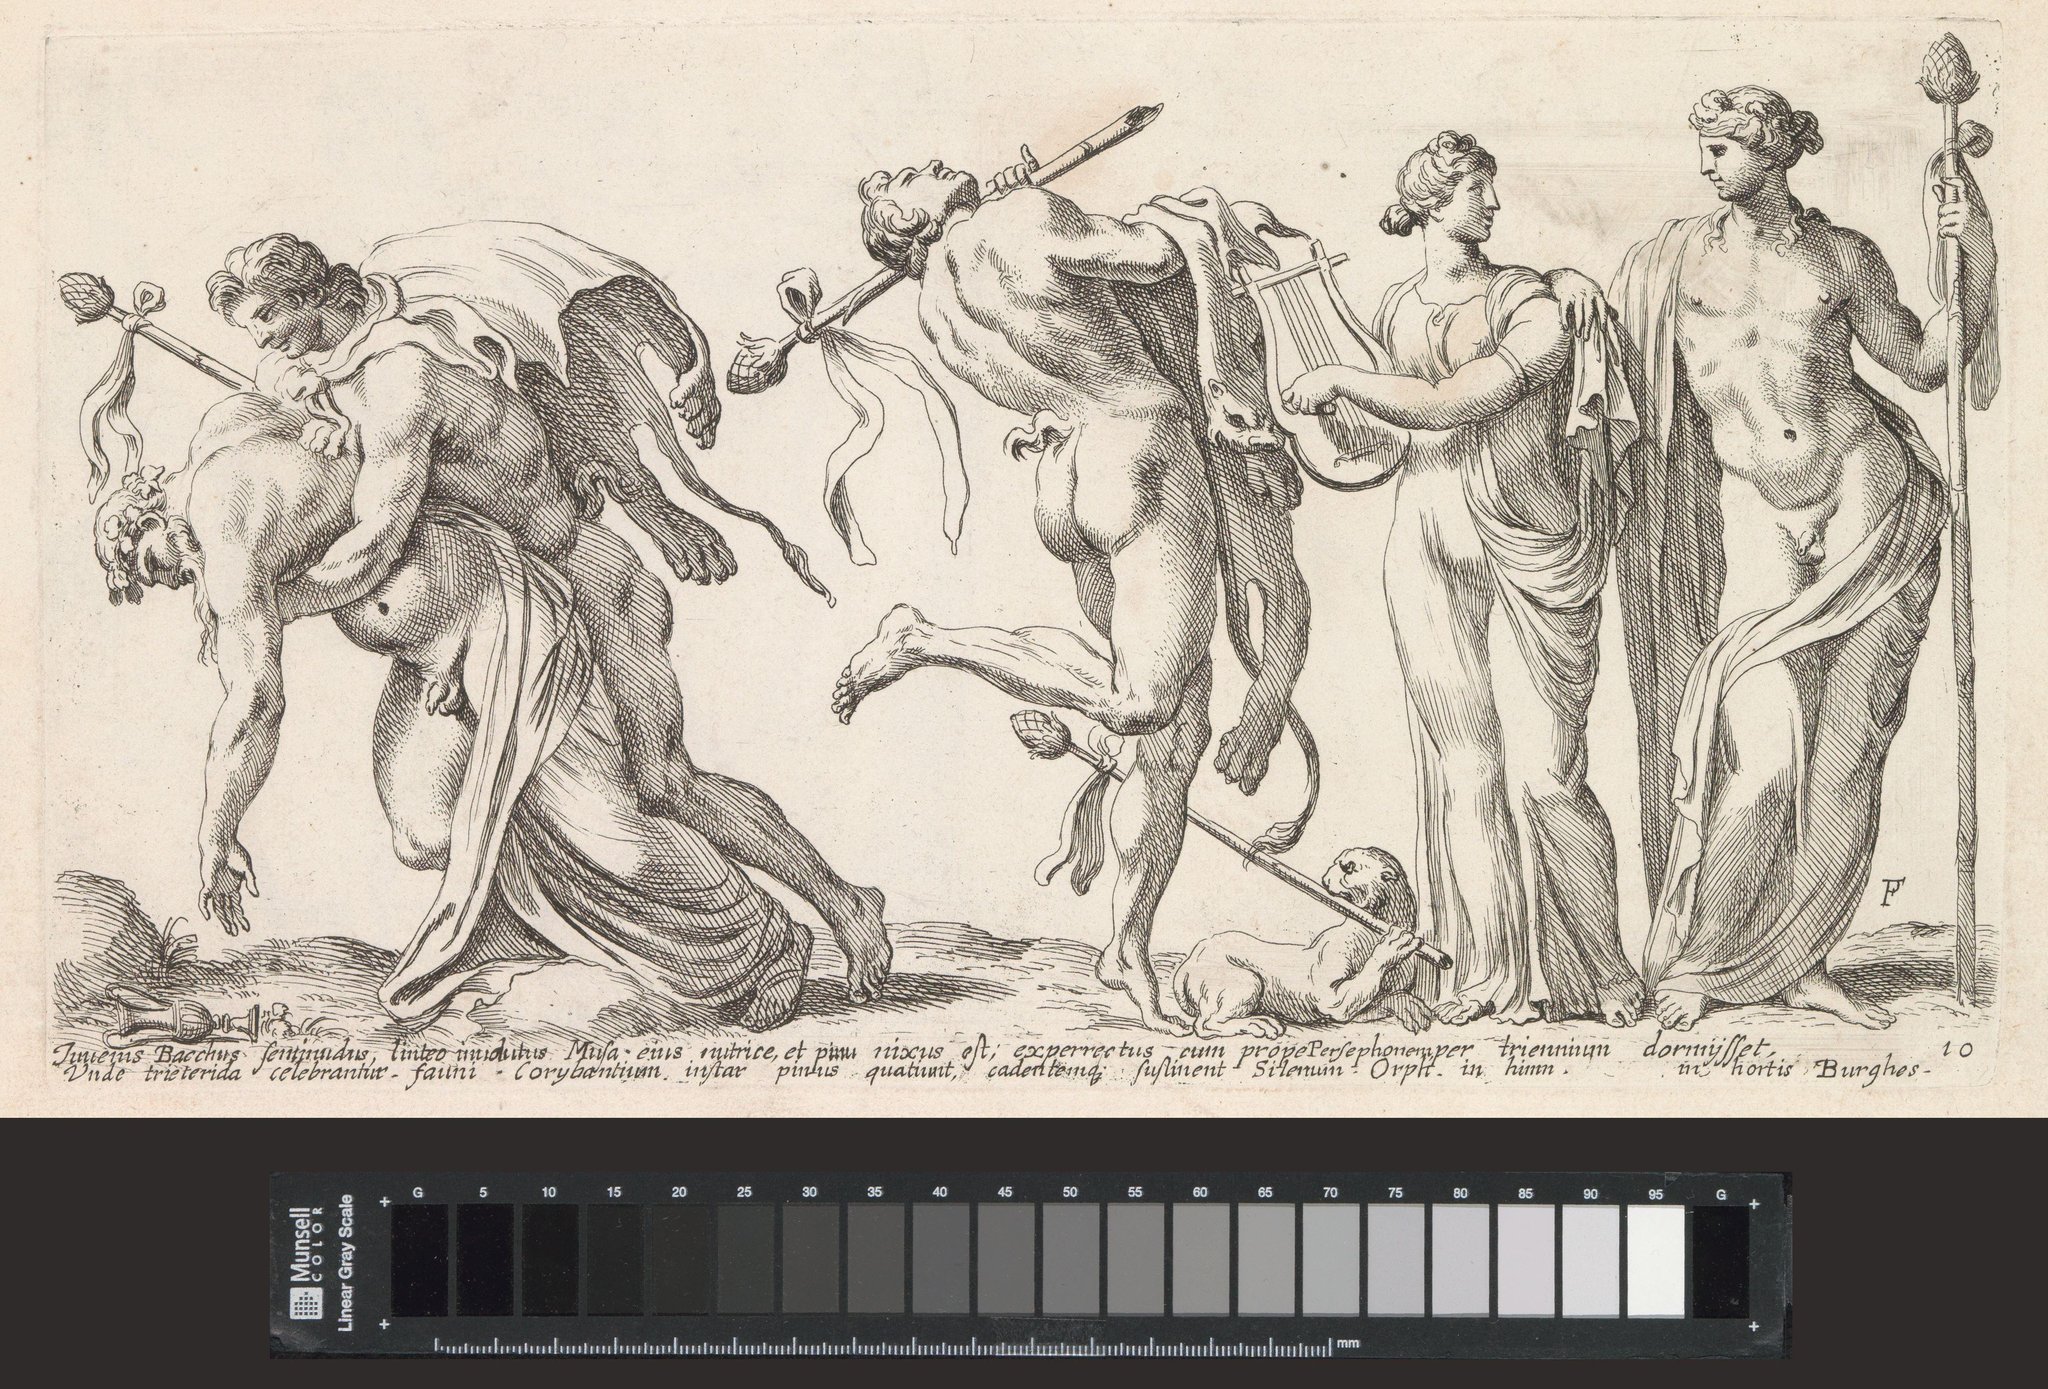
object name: print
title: Icones et segment (...)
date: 1645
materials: paper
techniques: etching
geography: paris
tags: maenad(s), female bacchant(es), male bacchant(es), piece of sculpture, reproduction of a piece of sculpture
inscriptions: number: ‘37’, inscription: ‘Ende lib. No. 4. [...] fol. 66 [...] fol. 71 et 138. lib. No. 10. fol. 57. 58. 71. 77. lib. No. 20. fol. 71.’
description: Deze prent maakt deel uit van een reeks van 54 prenten (+ titelprent) naar antieke reliëfs. De nummering op de prenten loopt van 1 tot en met 50. Sommige prenten hebben dubbele nummers. Naar een reliëf in Villa Borghese te Rome.